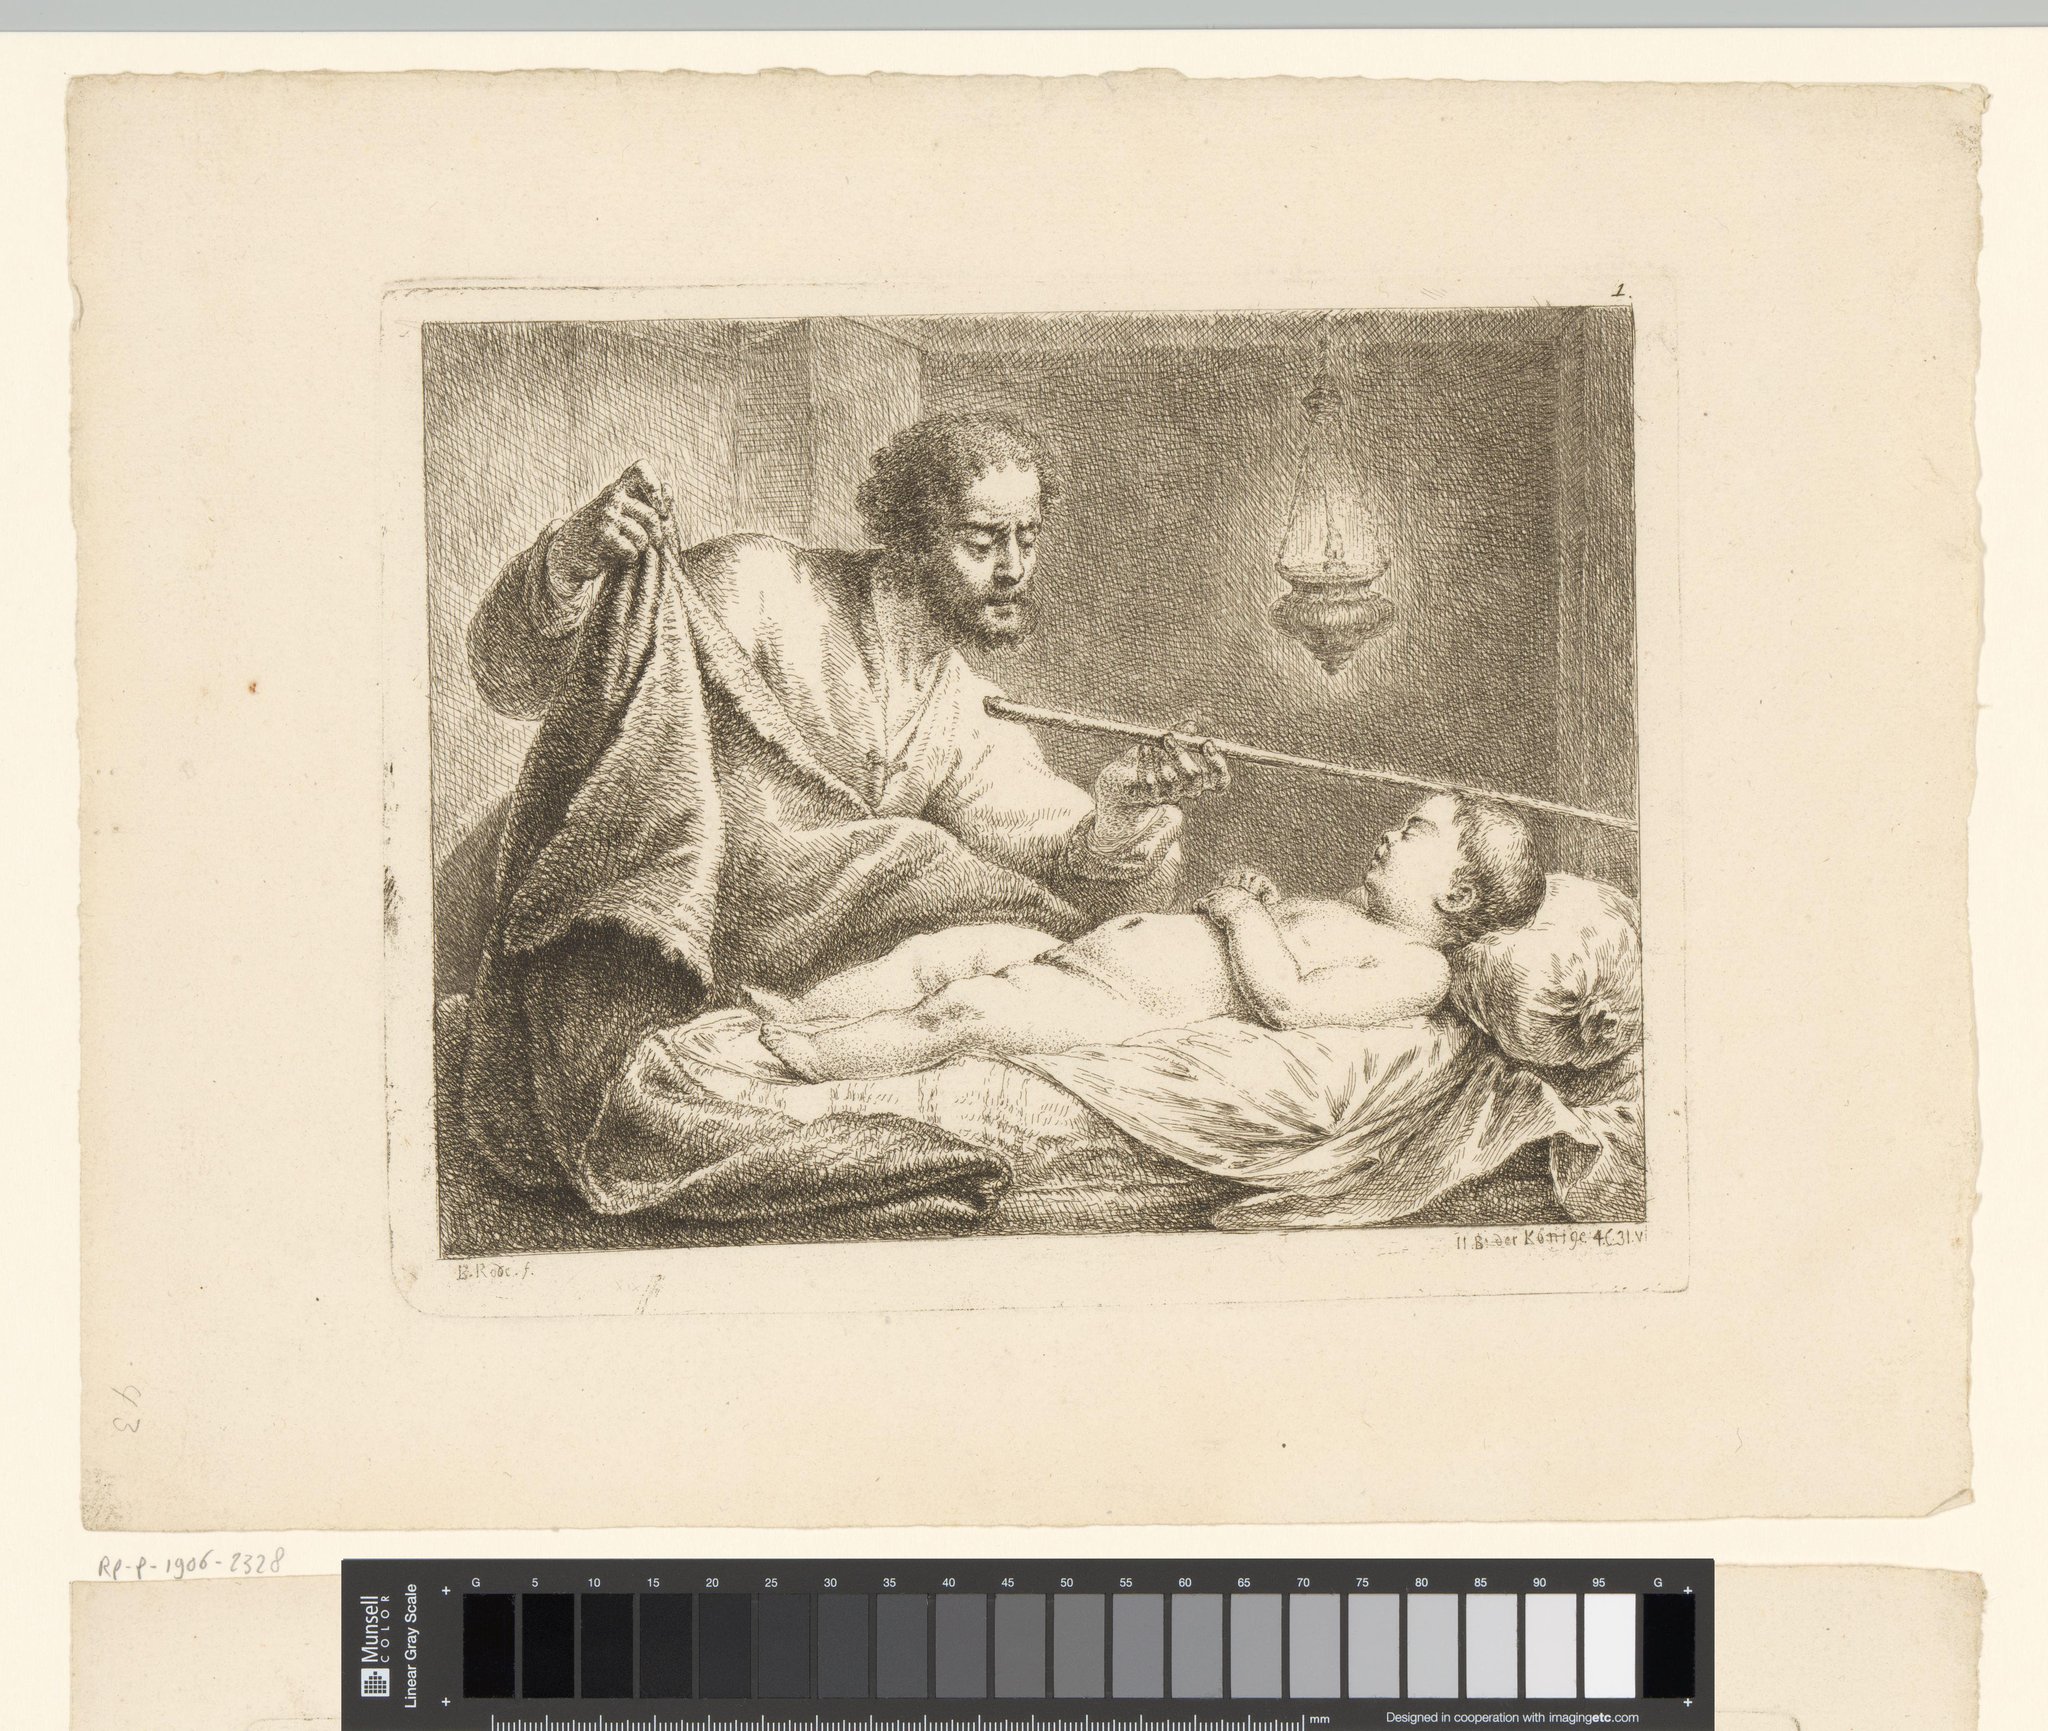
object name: print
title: Elia probeert het kind tot leven te wekken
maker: bernhard rode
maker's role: artist, print maker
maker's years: 1725-1797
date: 1780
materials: paper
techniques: etching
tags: elijah takes the child of the widow of zarephath and carries him upstairs (+ variant)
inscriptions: collector's mark: Lugt 2228